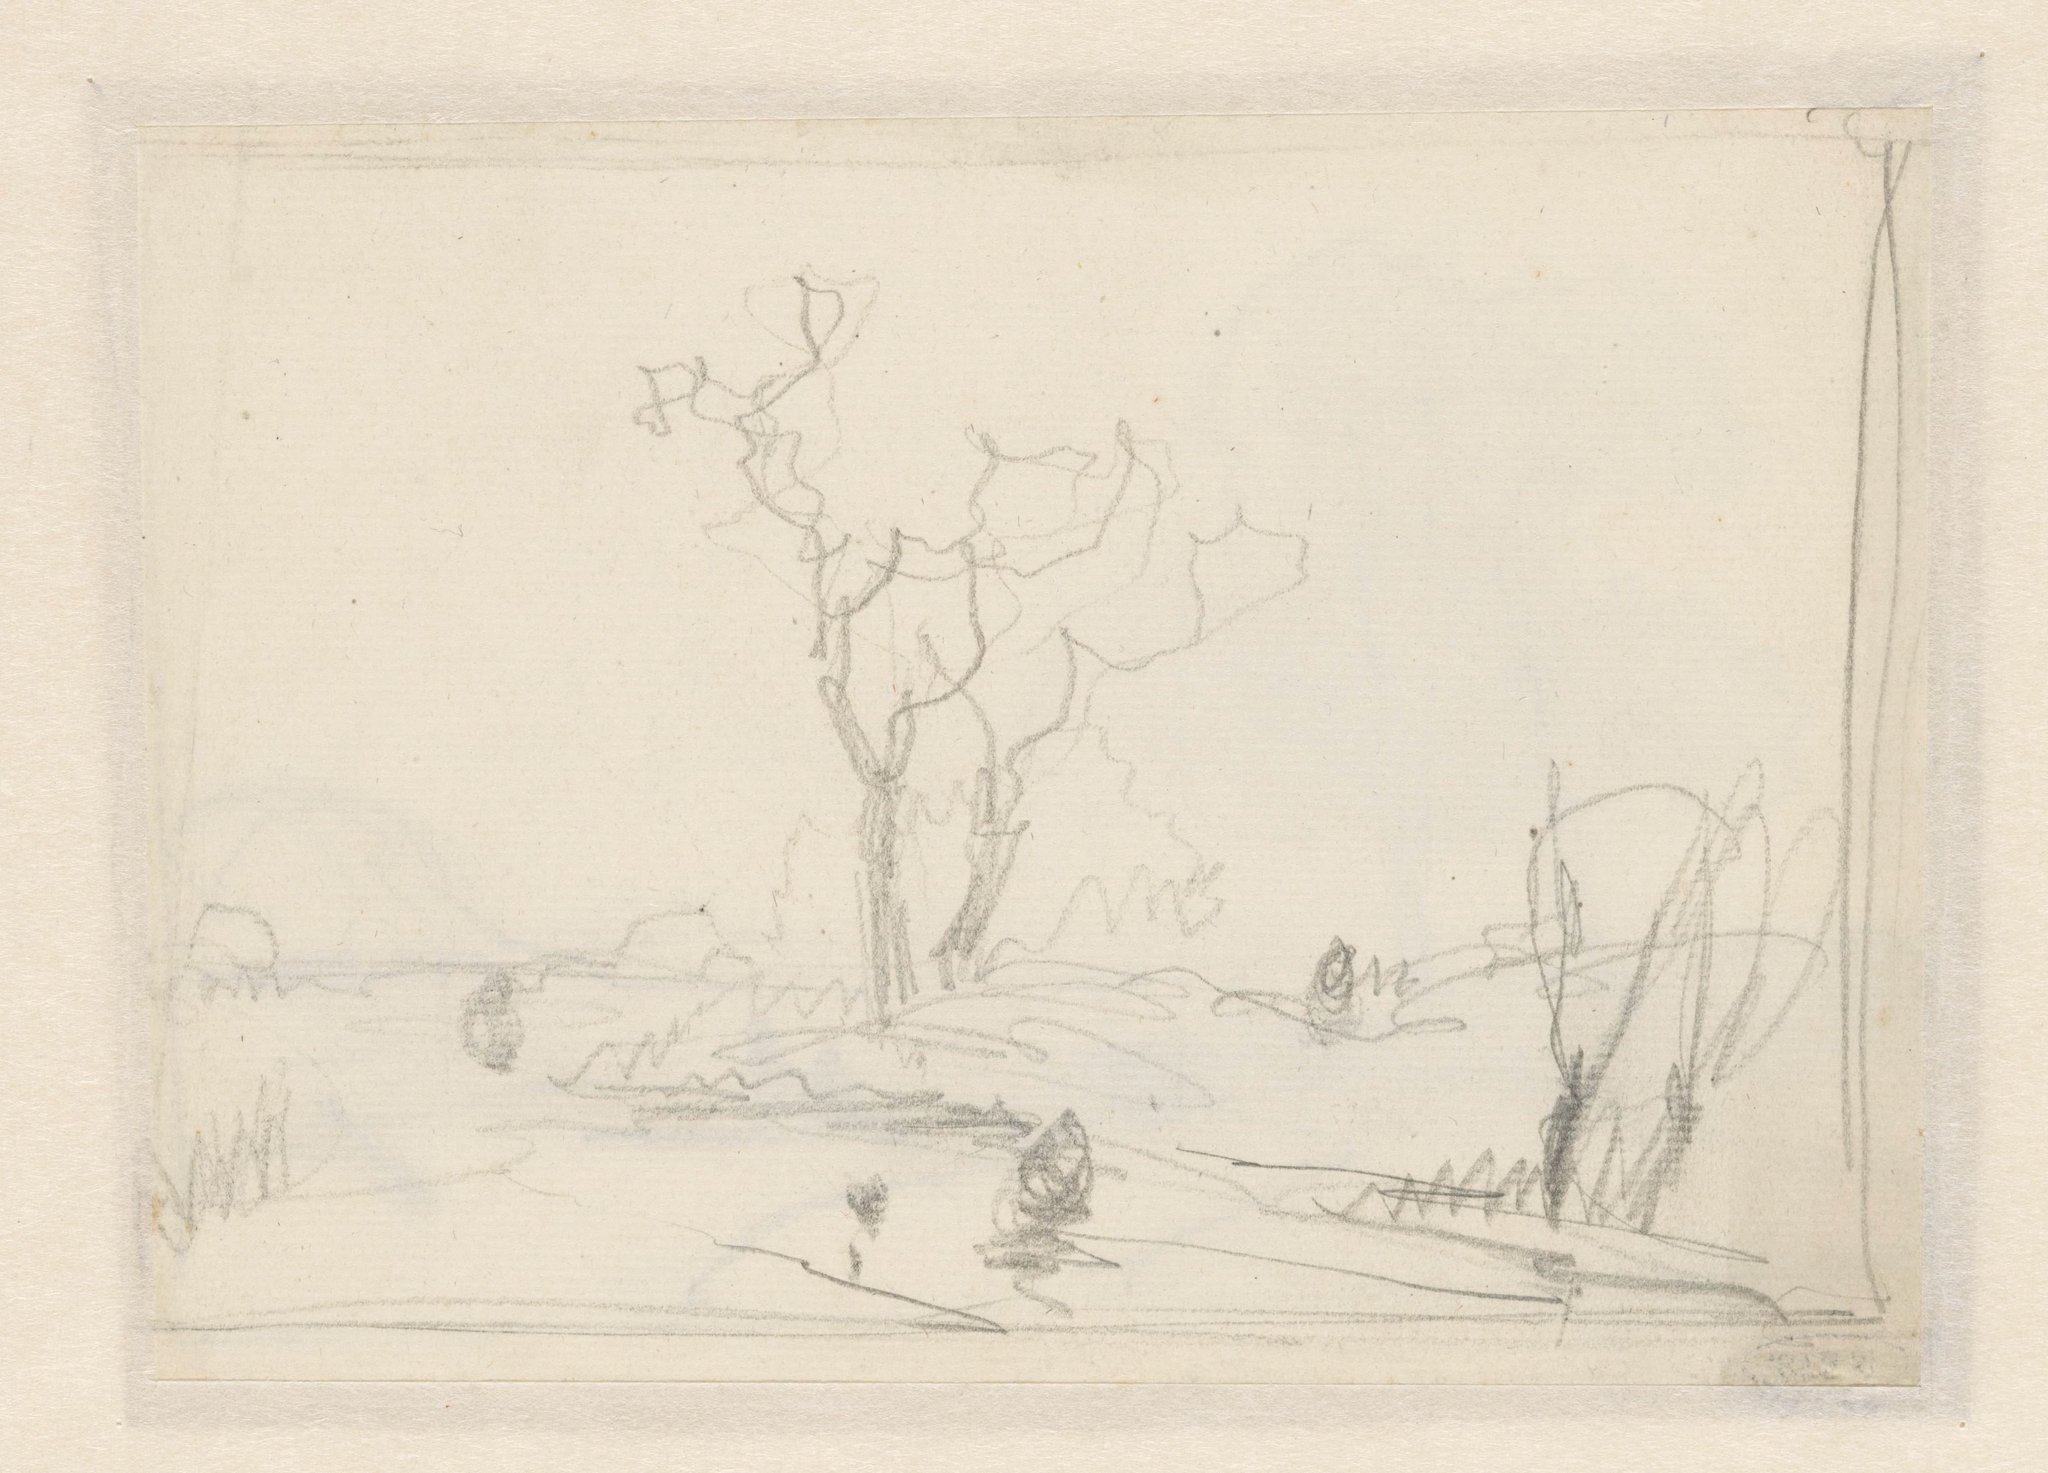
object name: drawing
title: Schets van een landschap met een kale boom in het midden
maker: andreas schelfhout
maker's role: draughtsman, painter, print maker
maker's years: 1787-1870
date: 1797-1870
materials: paper, pencil